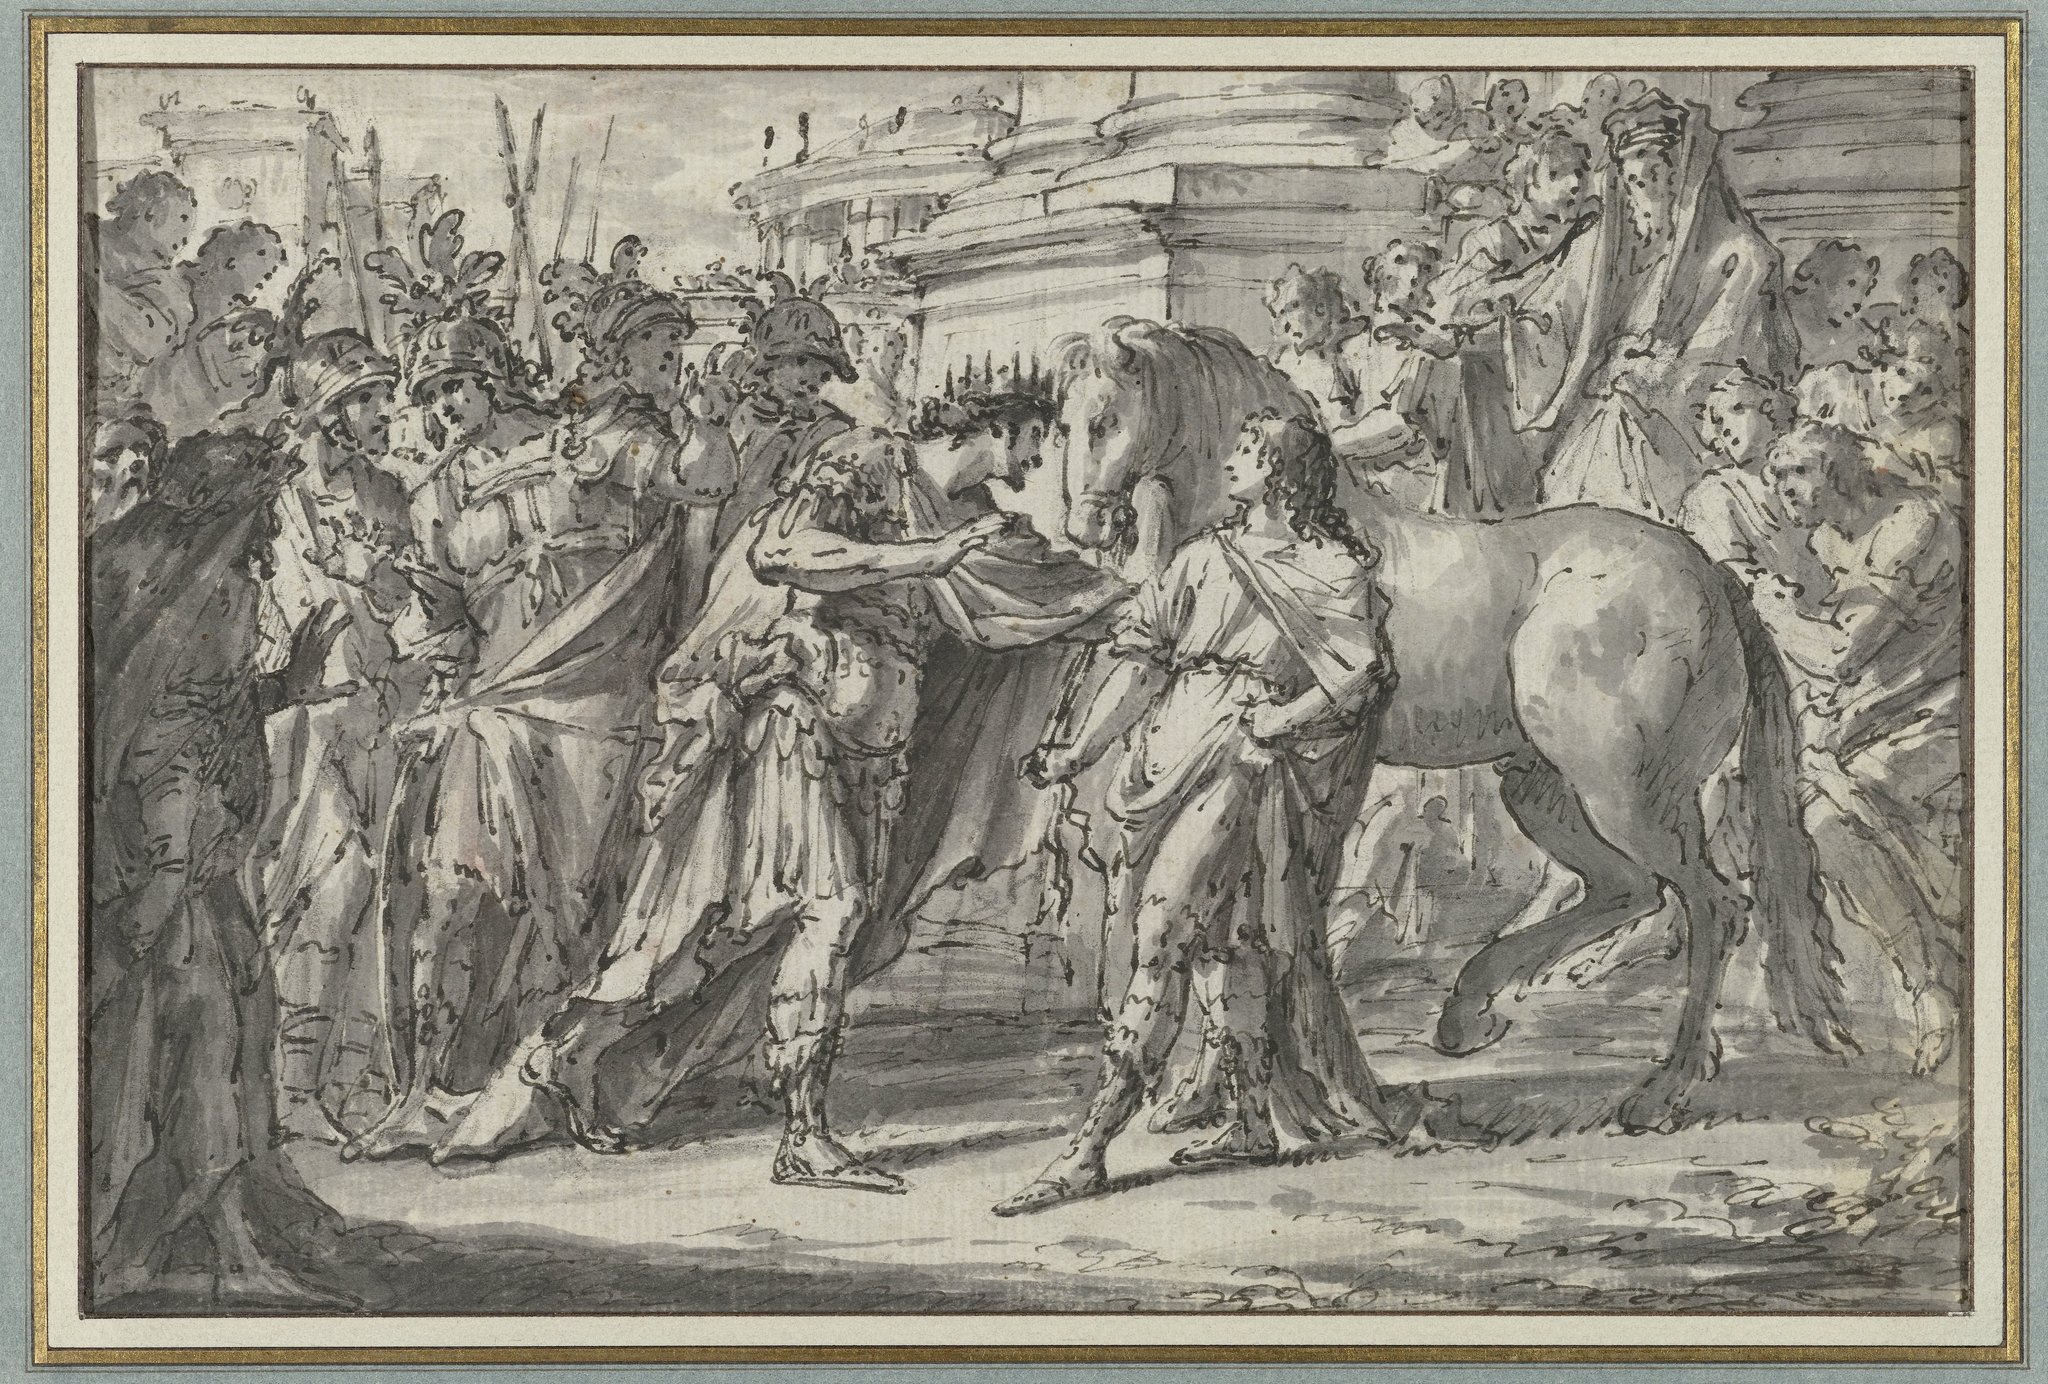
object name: drawing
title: Koning Philippus II van Macedonië schenkt zijn zoon Alexander het paard Bucephalus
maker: fidele fischetti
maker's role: draughtsman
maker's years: 1732-1797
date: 1742-1797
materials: ink, paint, paper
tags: koning, philippus ii van macedonië